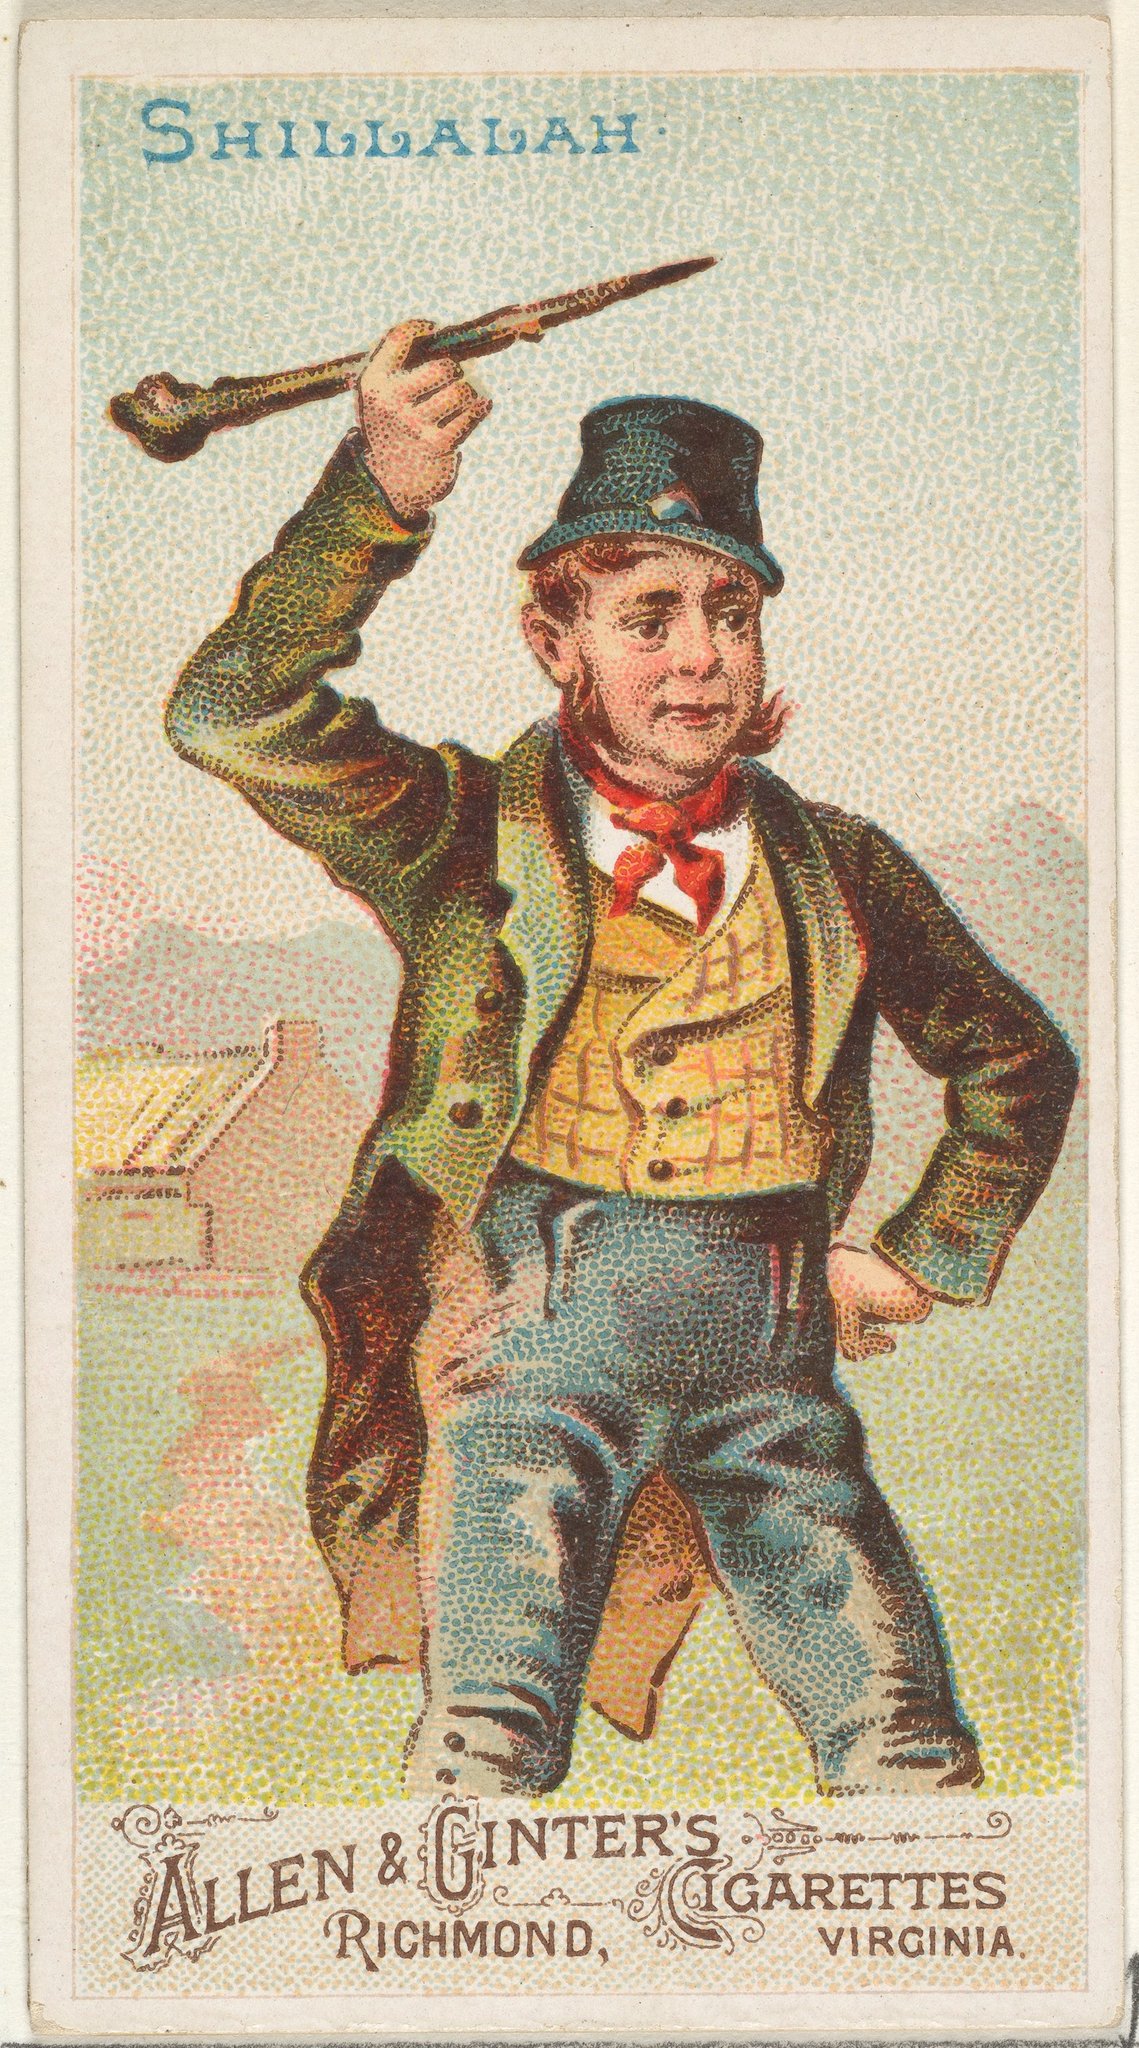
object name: print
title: Shillalah, from the Arms of All Nations series (N3) for Allen & Ginter Cigarettes Brands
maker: allen & ginter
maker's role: publisher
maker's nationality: american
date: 1887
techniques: color lithograph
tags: weapons,men